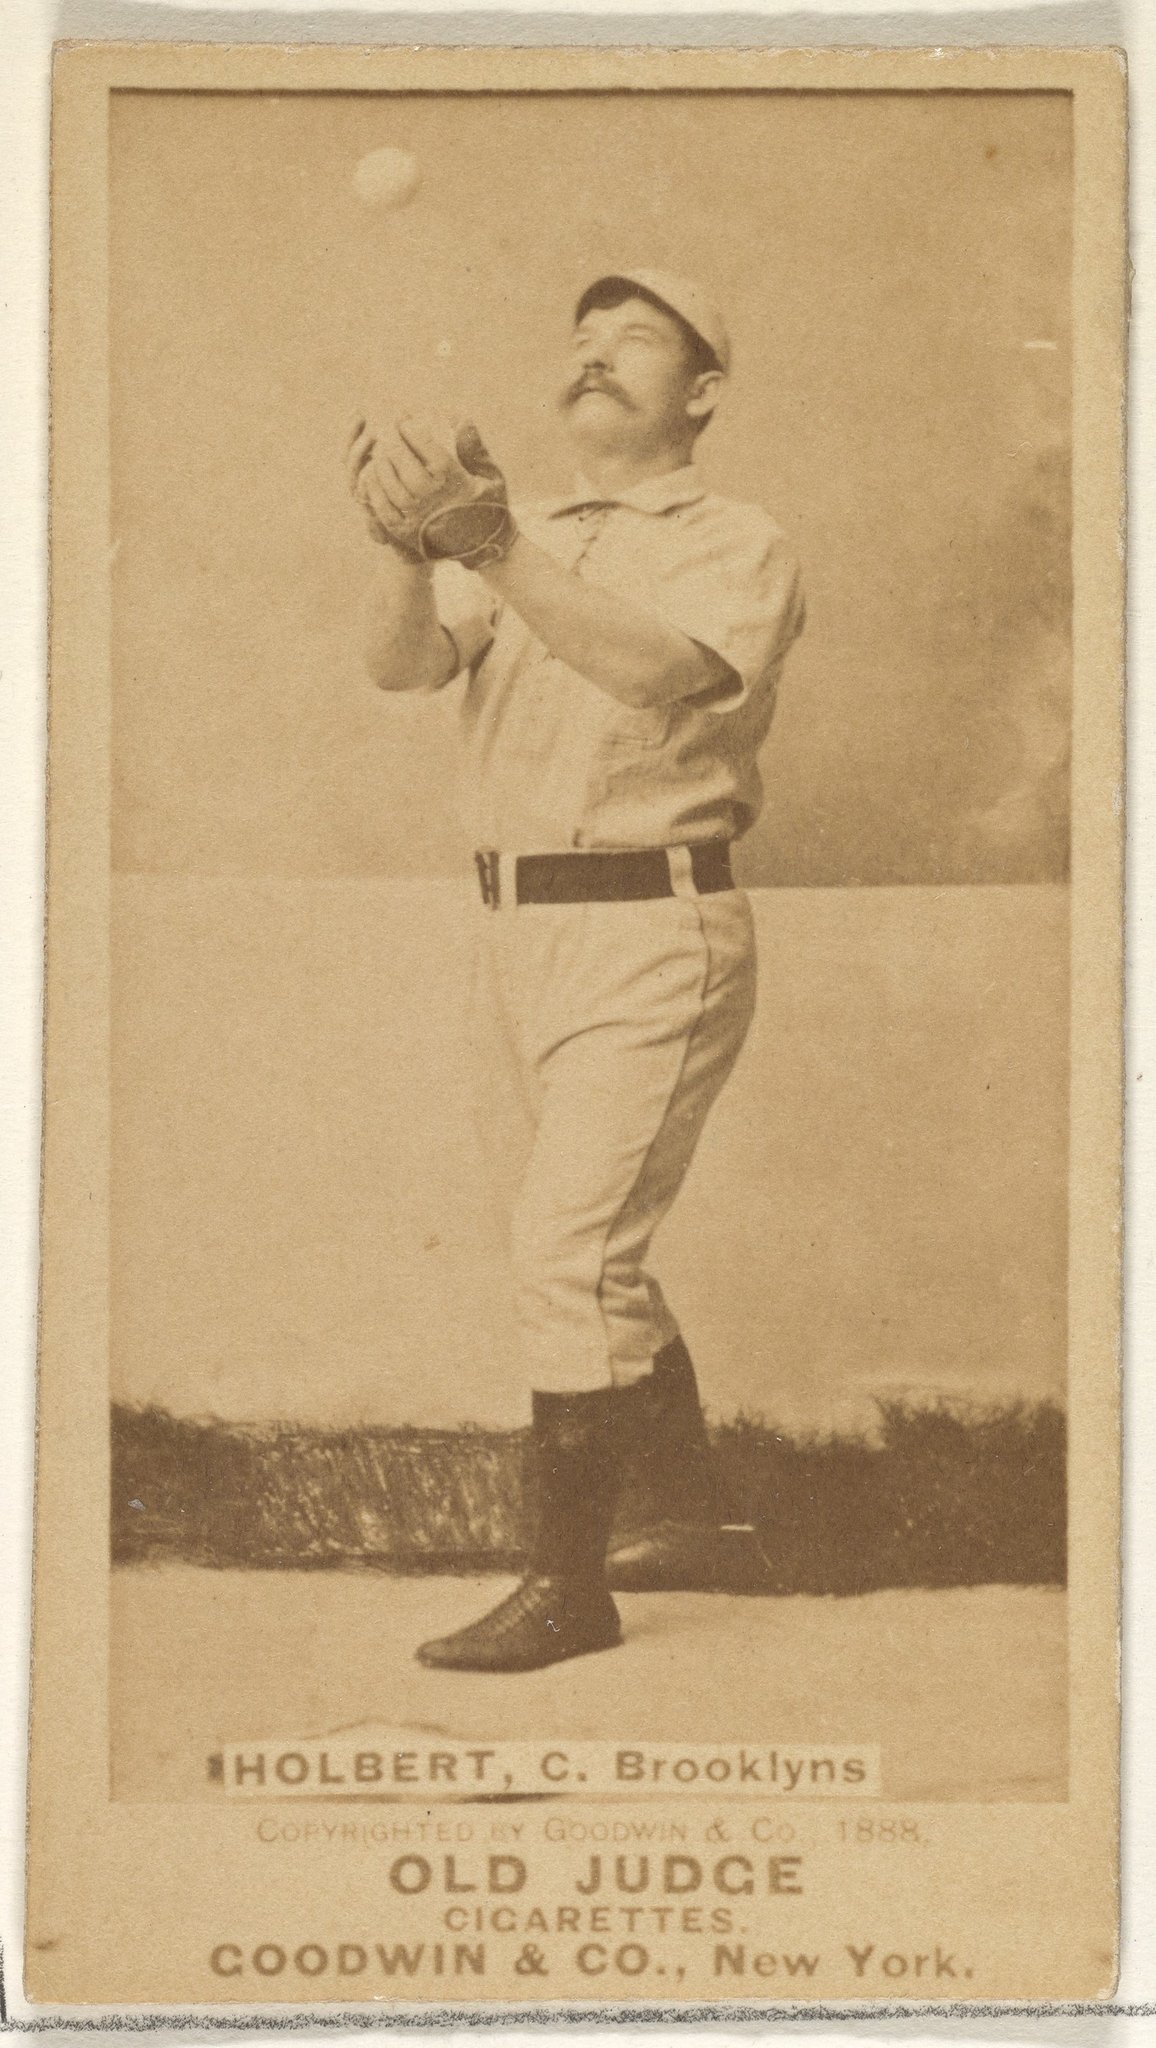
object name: baseball card, photograph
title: Holbert, Catcher, Brooklyn Bridegrooms, from the Old Judge series (N172) for Old Judge Cigarettes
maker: goodwin & company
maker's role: publisher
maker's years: 1850-1950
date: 1888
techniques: albumen silver print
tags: men,portraits,baseball,athletes